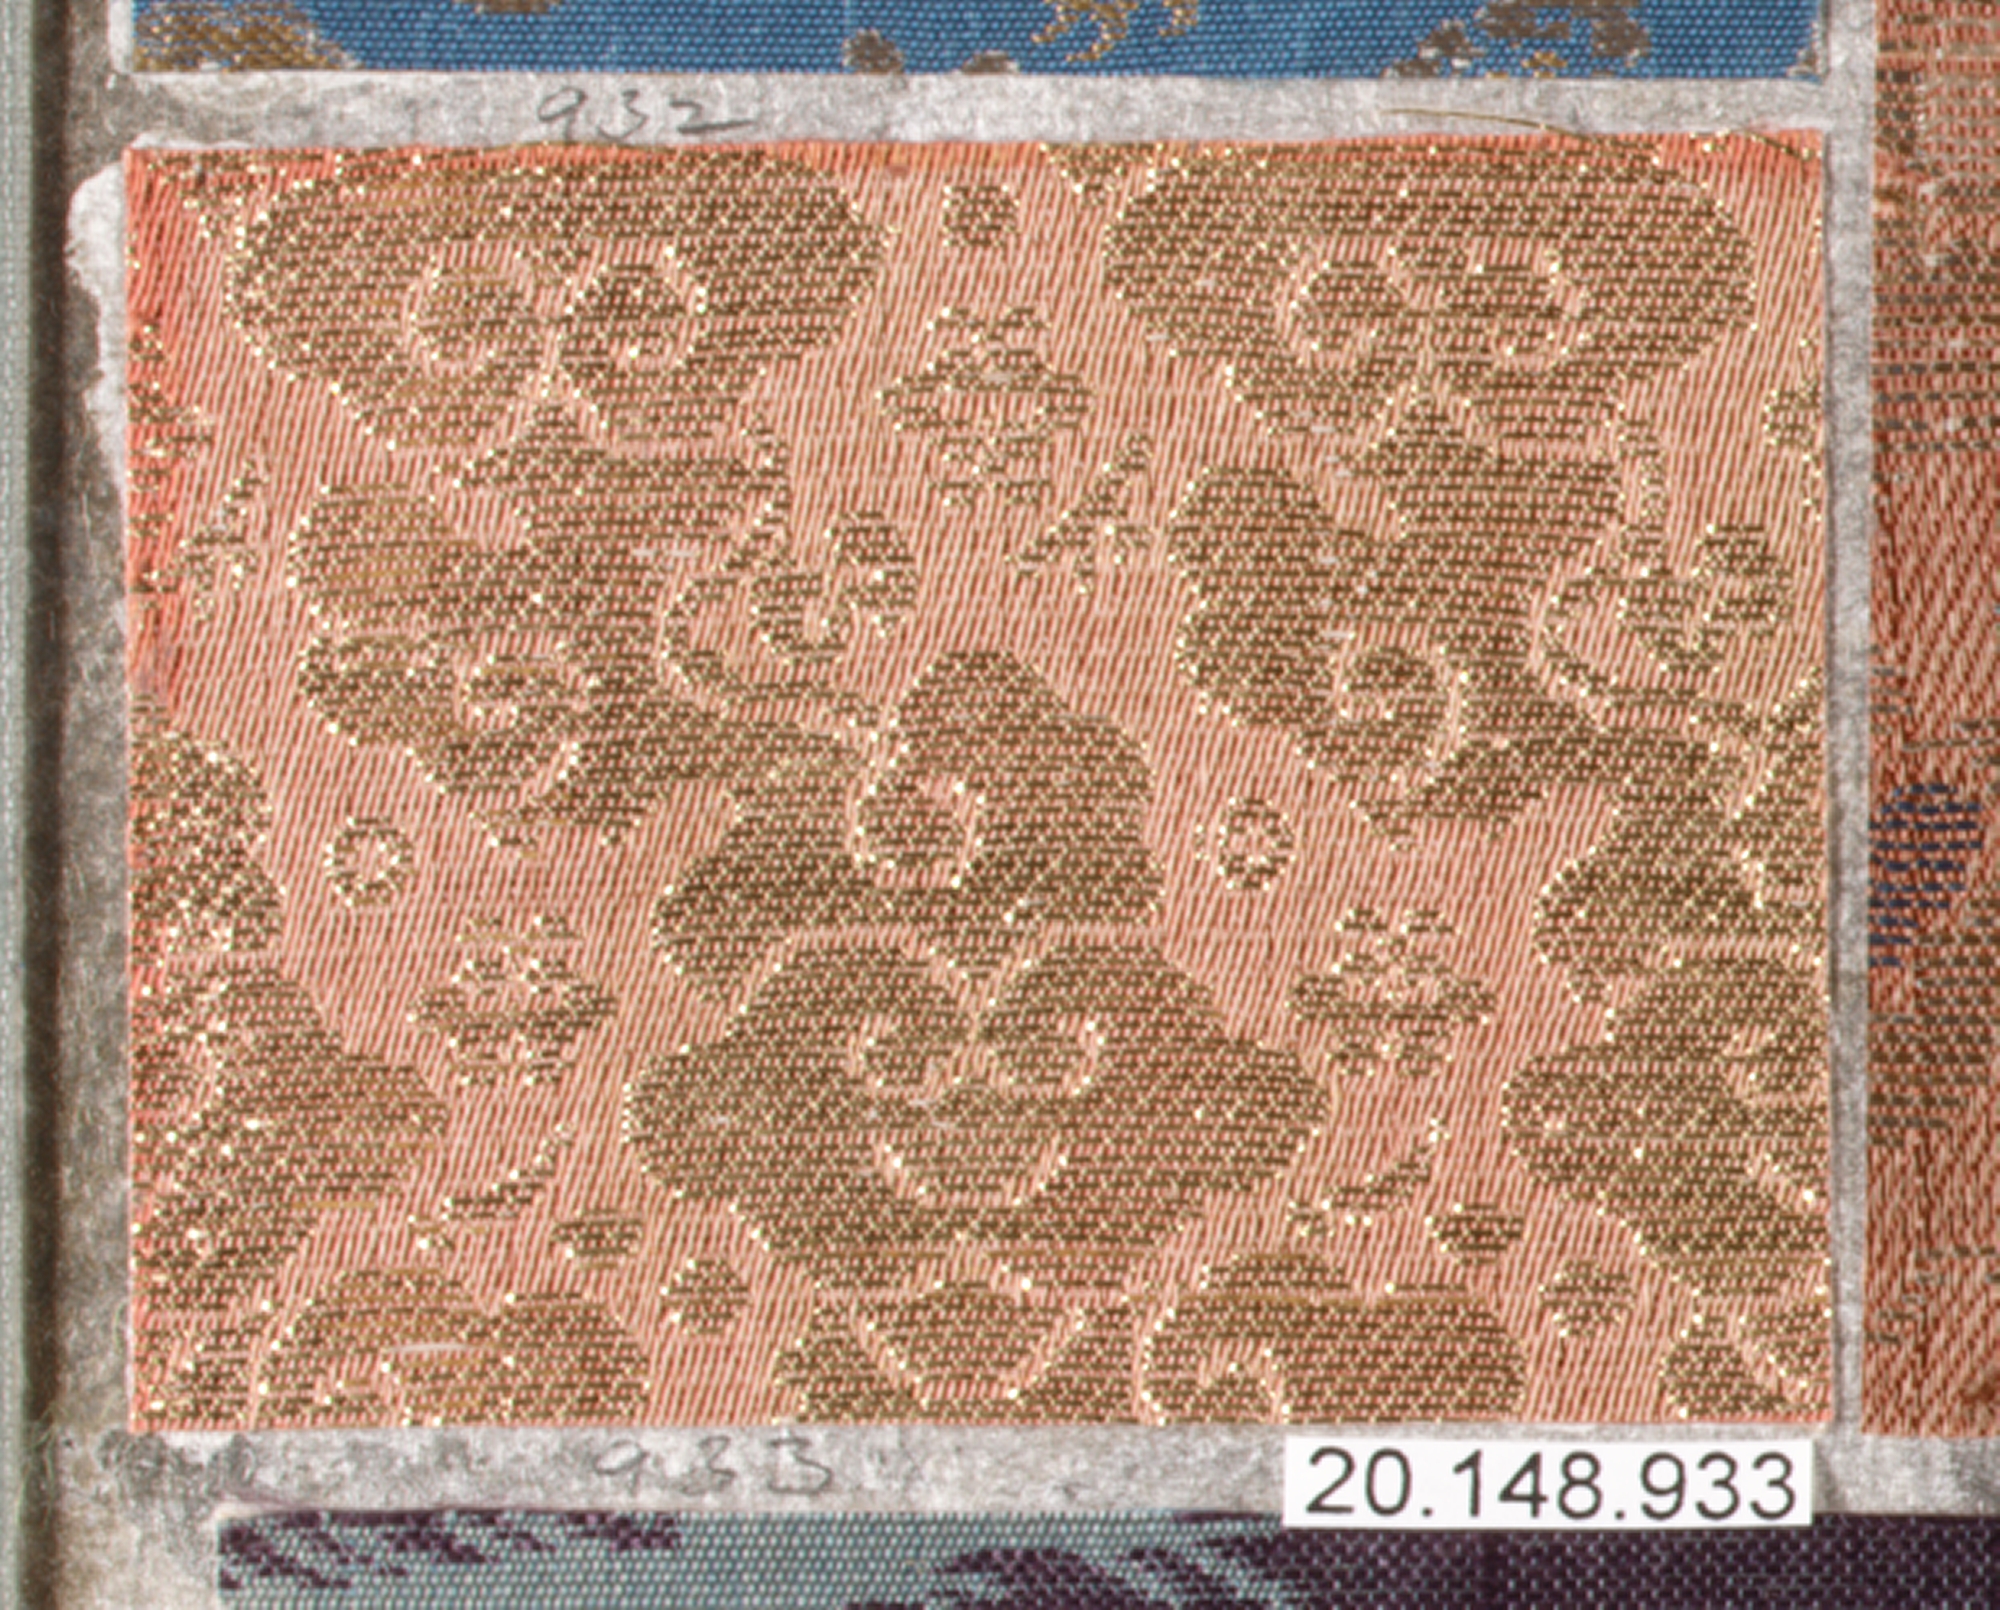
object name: piece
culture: japanese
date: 1701-1800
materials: silk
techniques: compound weave